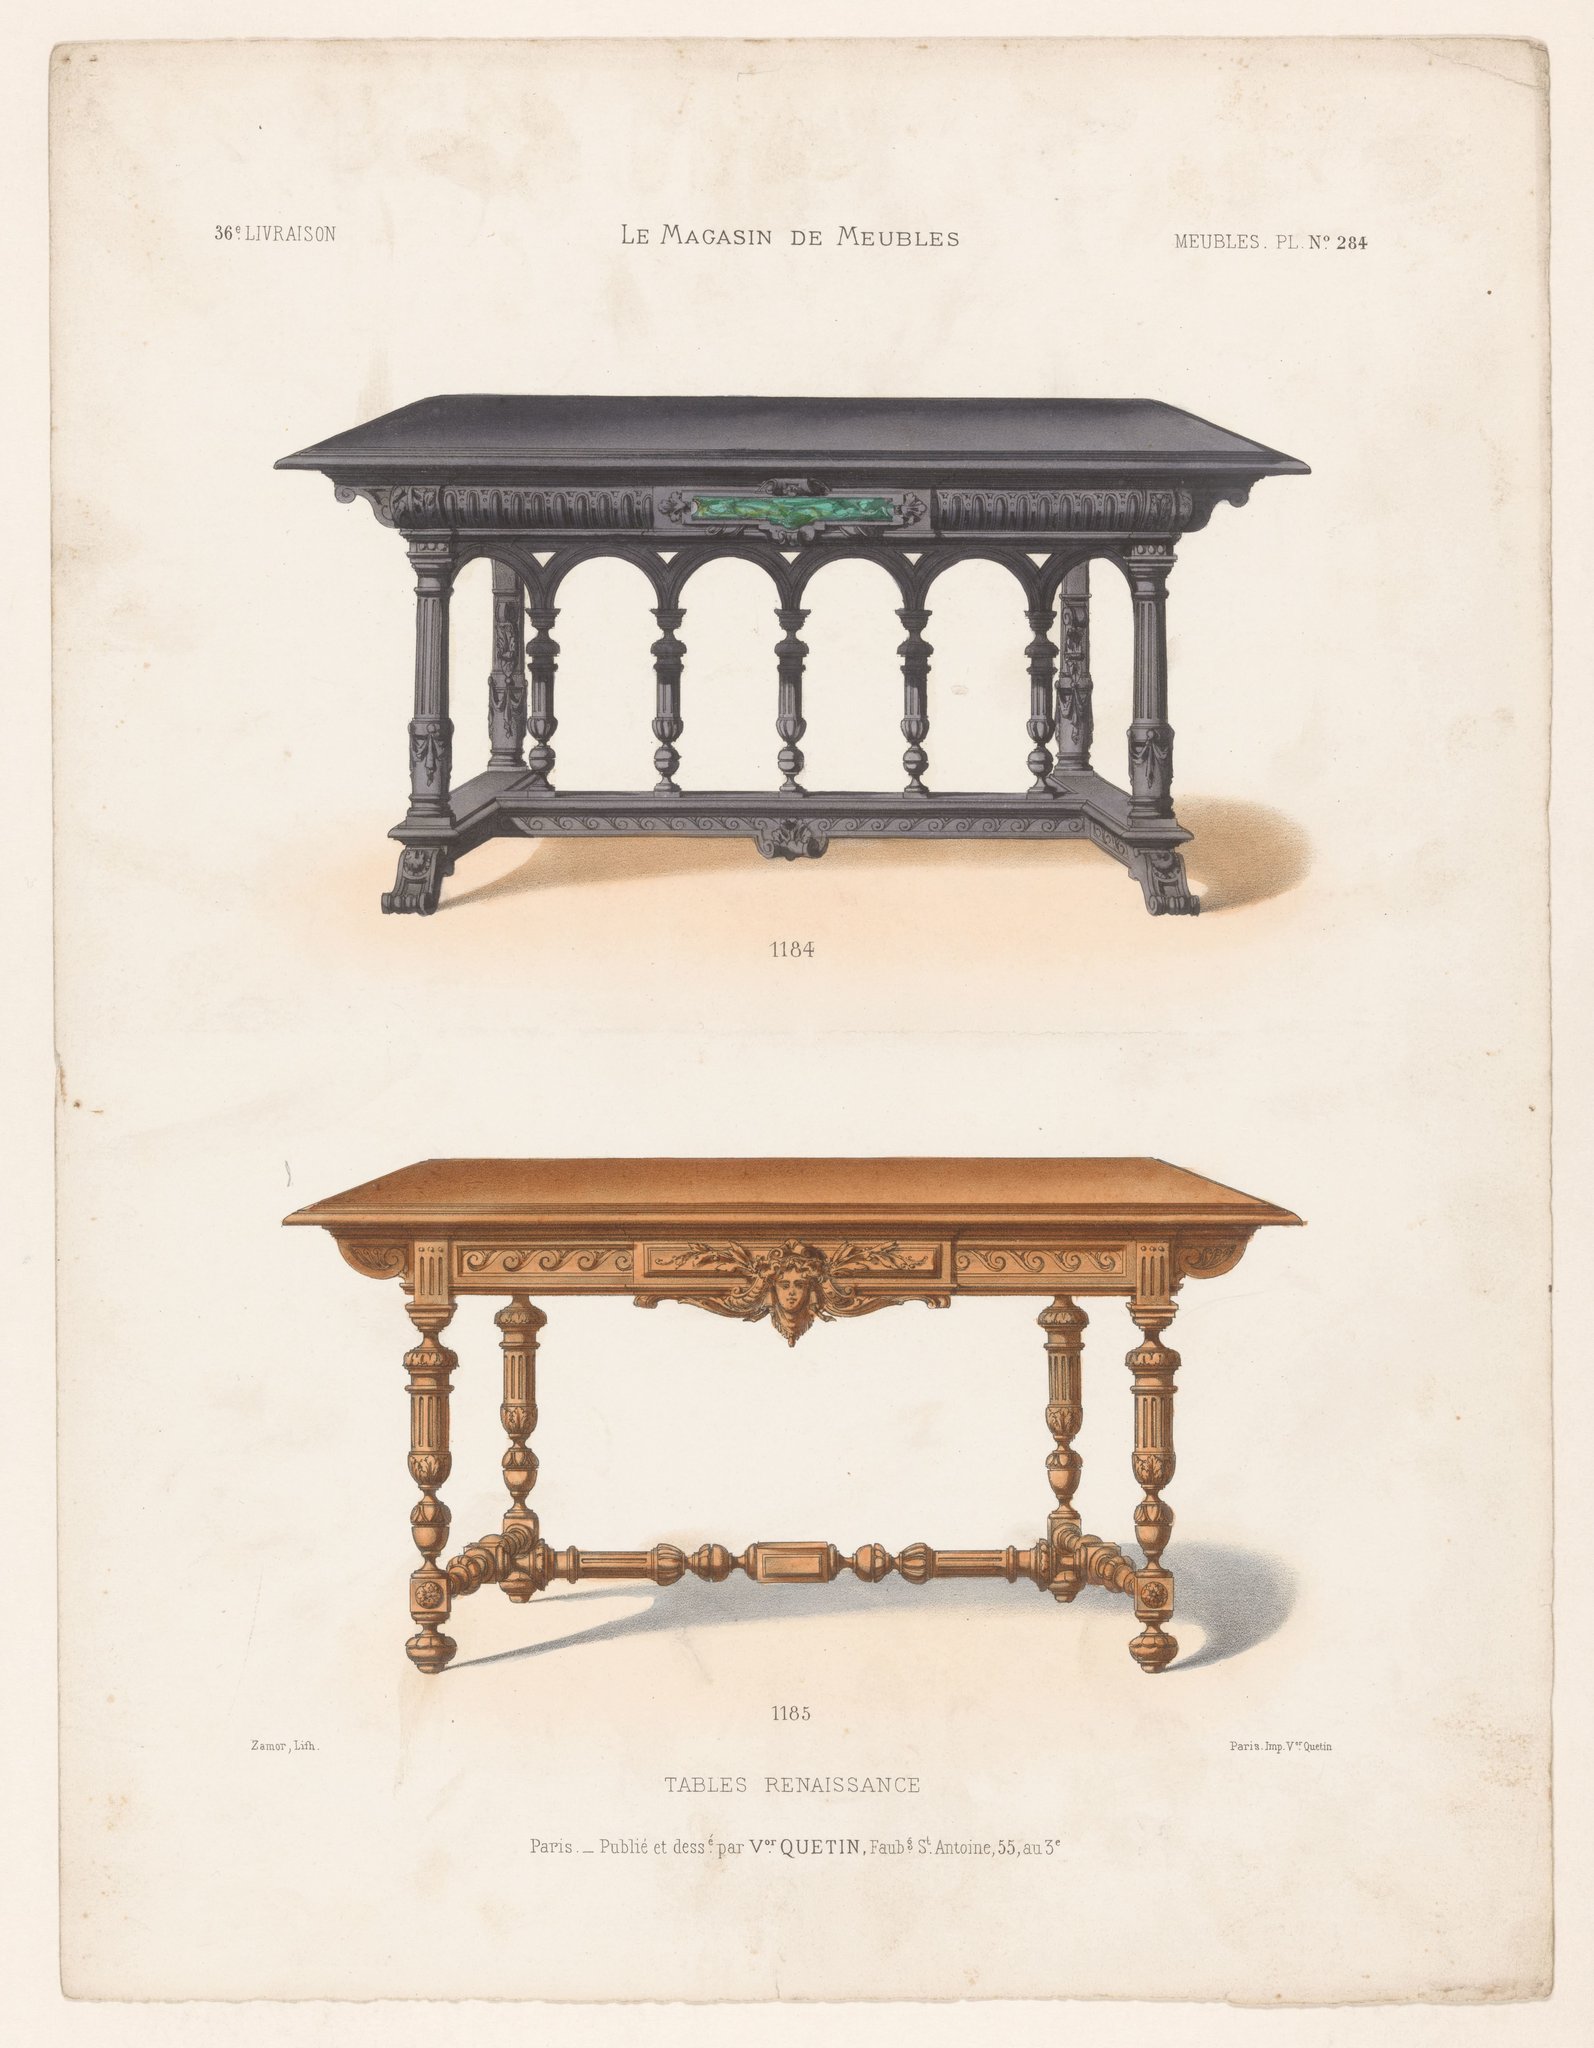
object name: print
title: Twee tafels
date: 1832-1877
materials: paper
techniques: hand coloring, lithograph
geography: paris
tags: table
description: Twee rechthoekige renaissance tafels. Prent uit 36e Livraison.